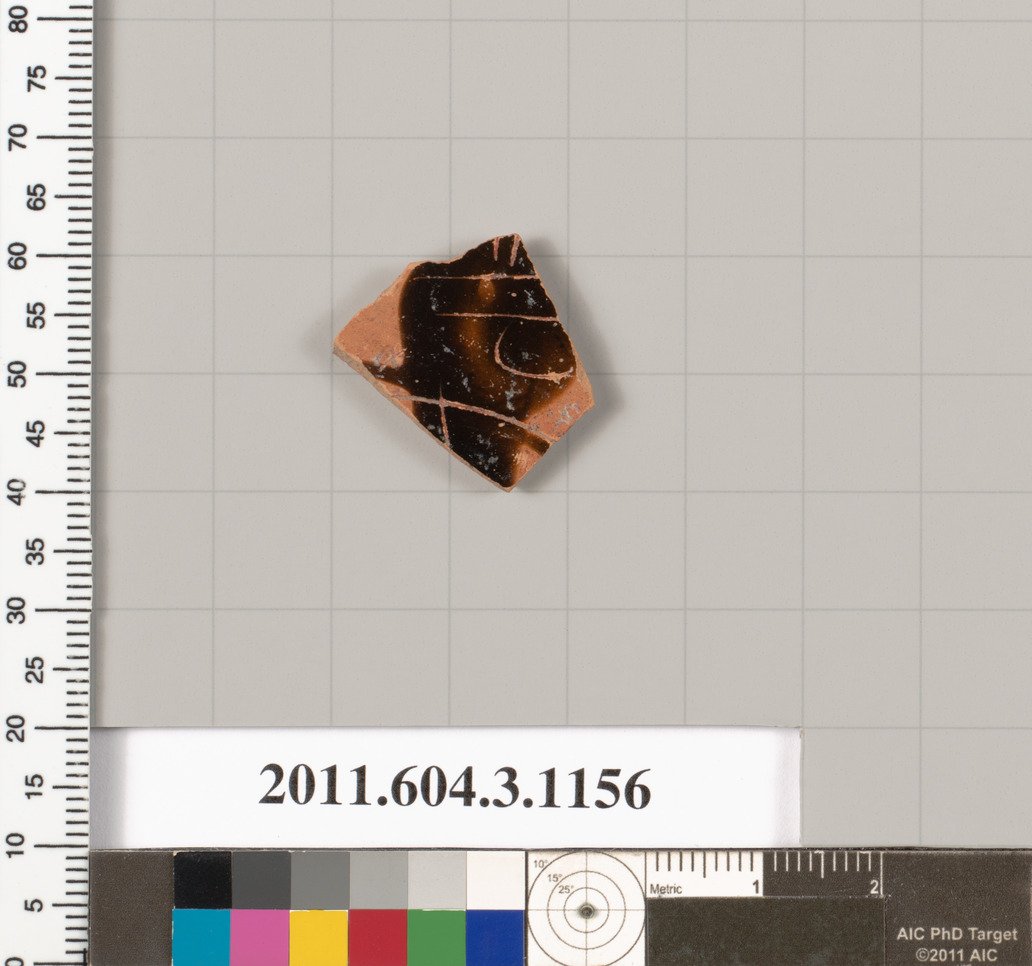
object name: mastoid or kyathos fragment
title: Terracotta fragment of a mastoid (drinking cup with narrow base) or a kyathos (cup-shaped ladle)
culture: greek, attic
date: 534-468 BCE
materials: terracotta